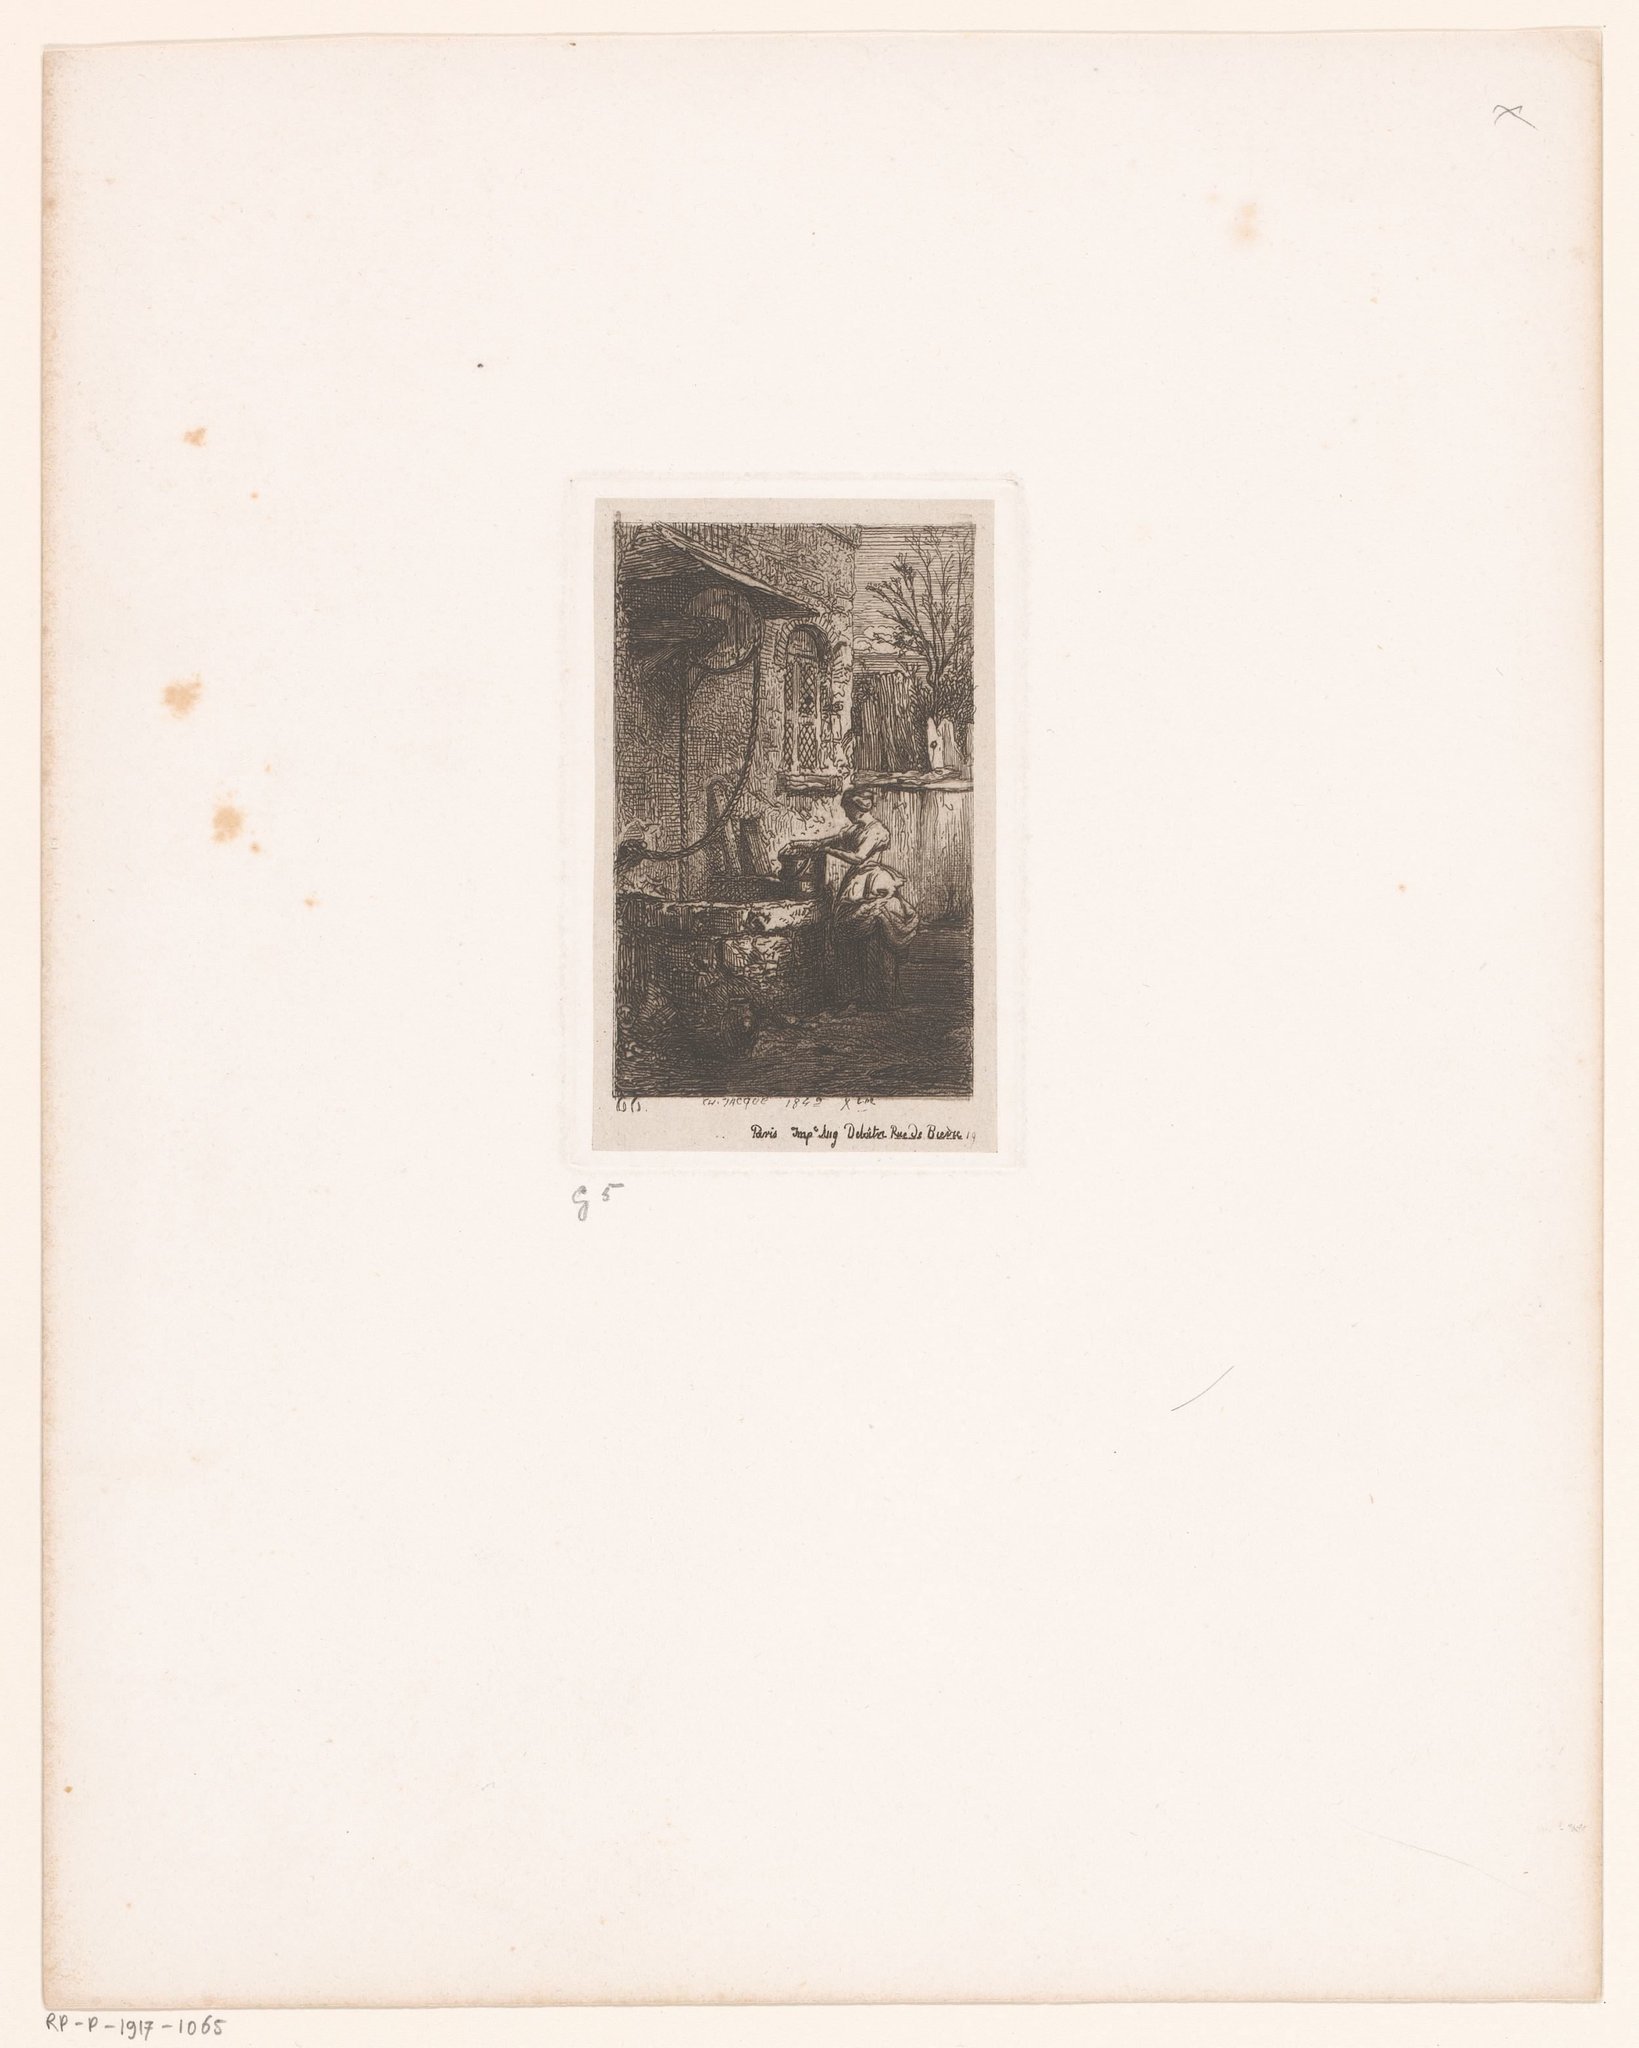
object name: print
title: Vrouw bij een waterput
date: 1842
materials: paper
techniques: etching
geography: paris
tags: well, wooden container: barrel, cask, bucket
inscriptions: collector's mark: Lugt 2233